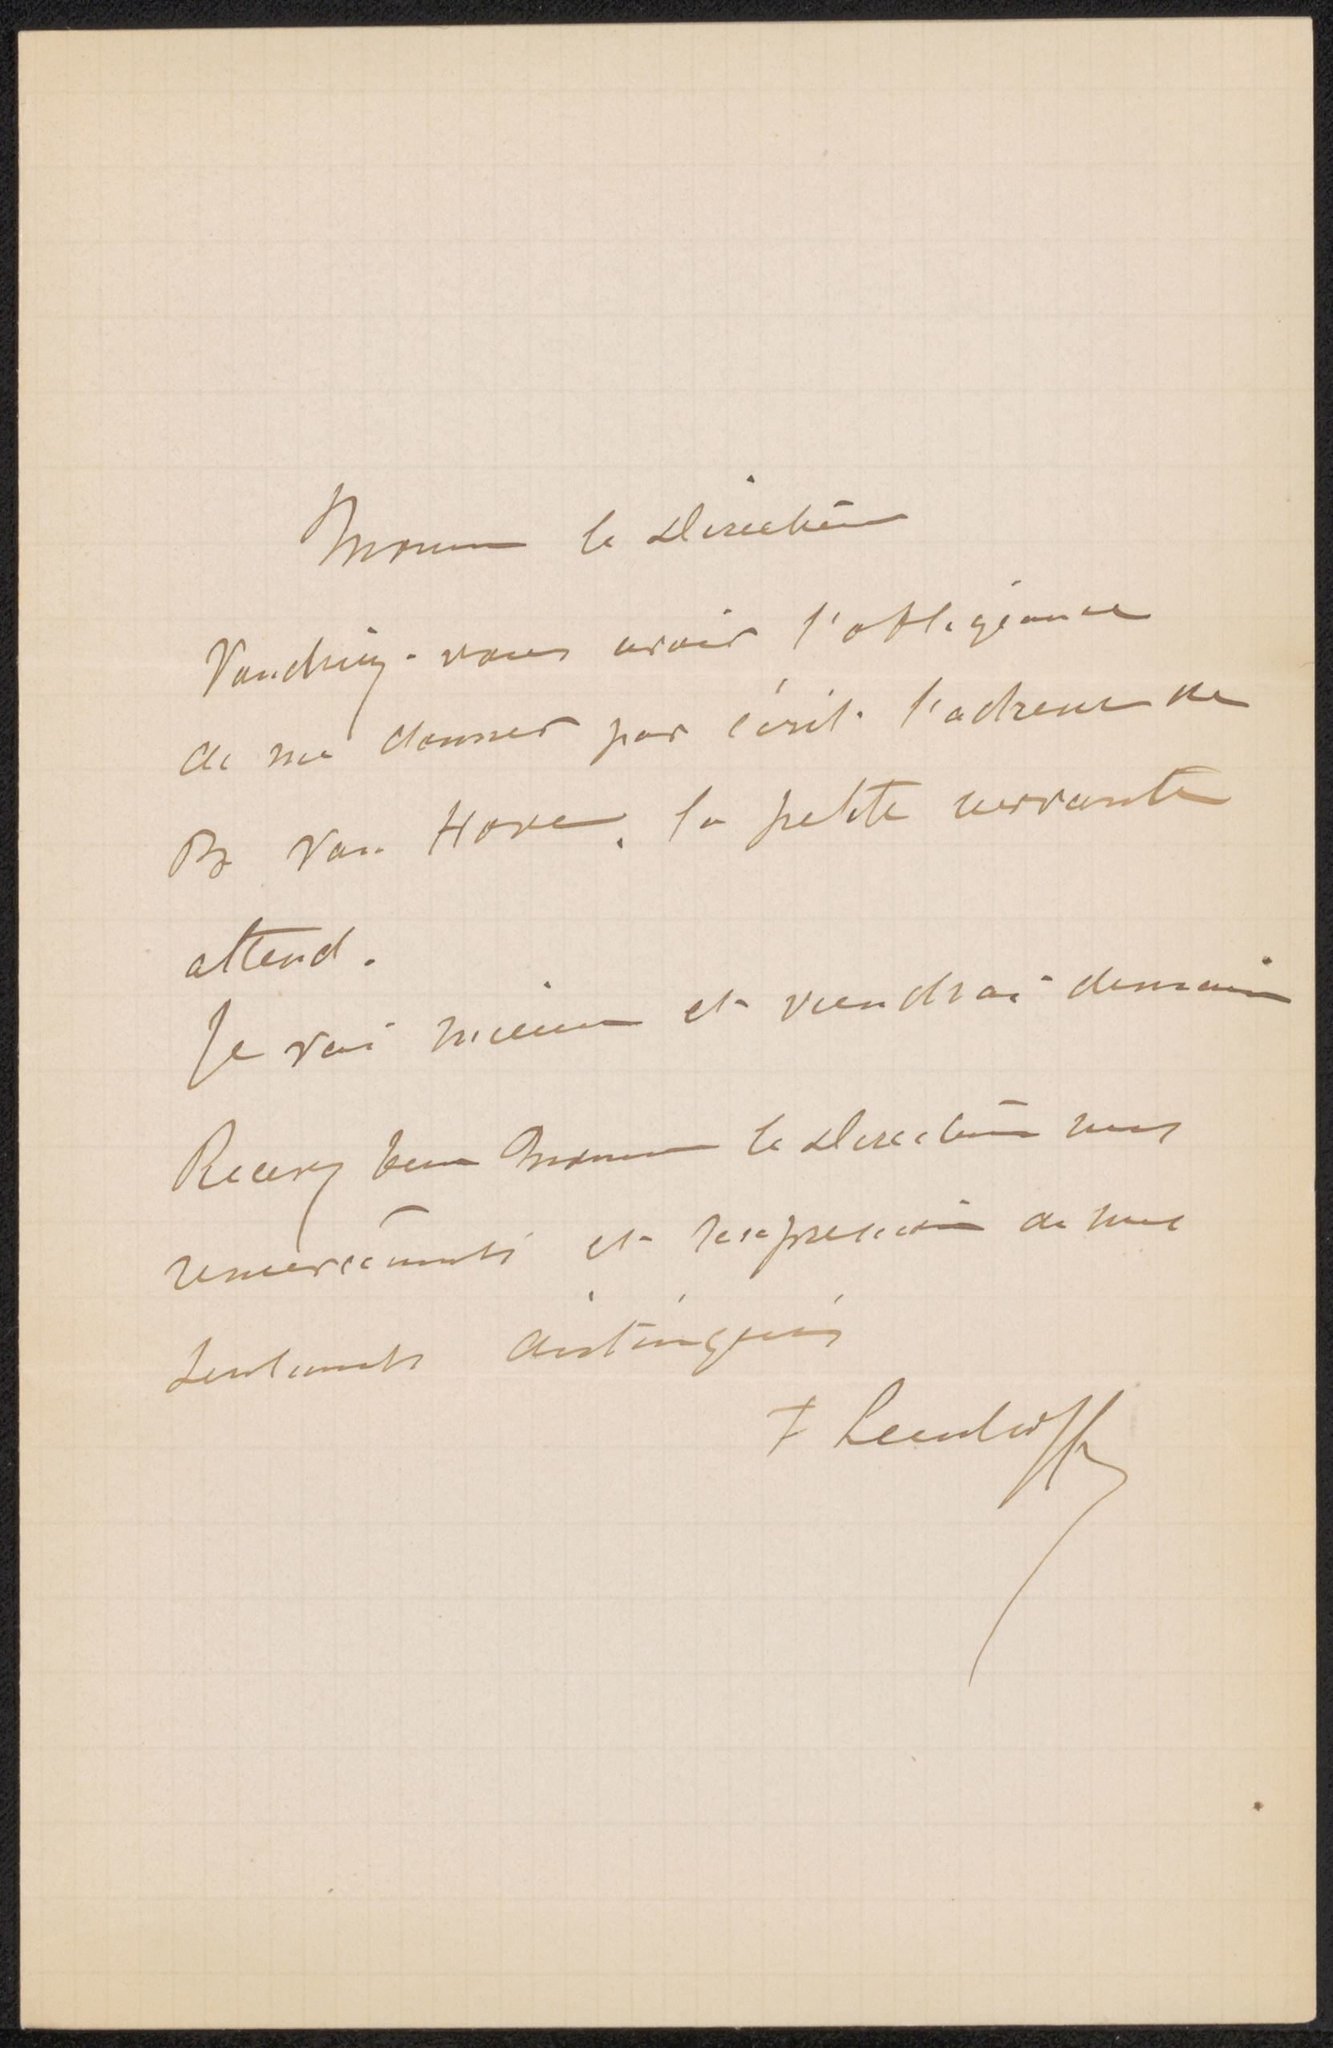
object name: letter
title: Brief aan August Allebé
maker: ferdinand leenhoff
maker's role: print maker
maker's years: 1841-1914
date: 1851-1914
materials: ink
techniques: pen, writing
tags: draughtsman, august allebé, the hague, amsterdam, sculptor, bart van hove